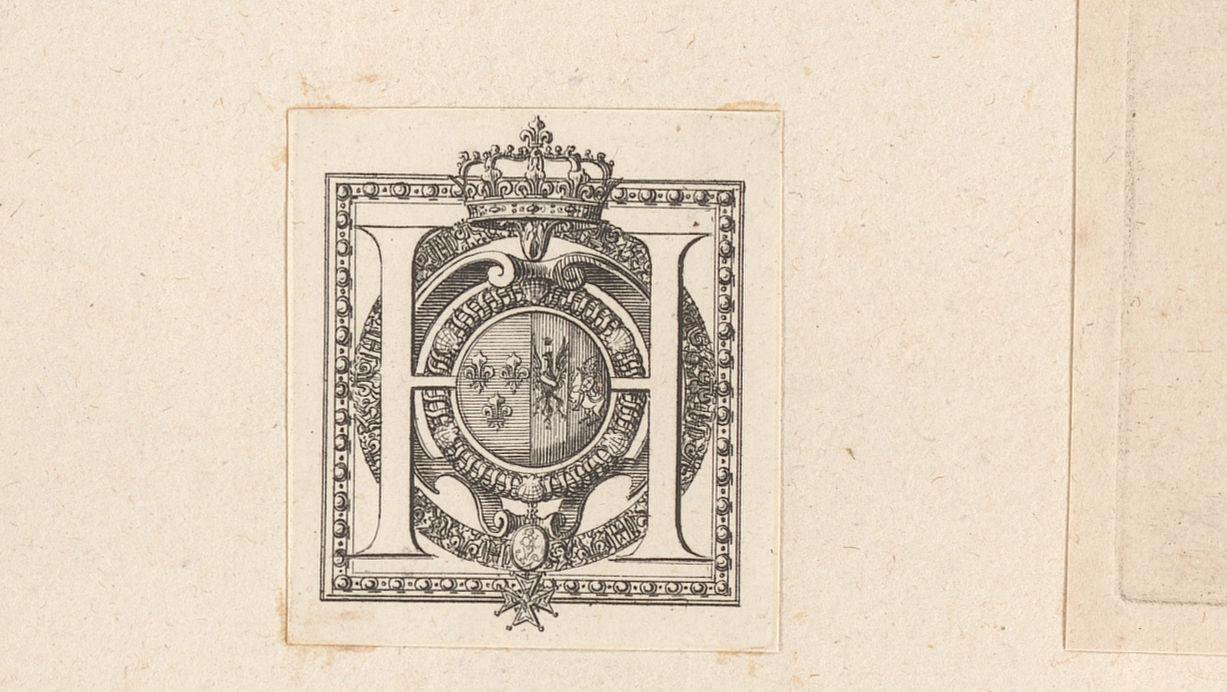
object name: album leaf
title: Initiaal 'H' met het wapen van Hendrik III en twee onderscheidingen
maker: sébastien leclerc (i)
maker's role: print maker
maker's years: 1637-1714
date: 1703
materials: paper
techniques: etching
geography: paris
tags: initial, knighthood order of the holy spirit - insignia of a knighthood order, e.g.: badge, chain (with name of order), insignia and symbols of sovereignty (crown, diadem, sceptre, orb, seal, standard, cloak, pectoral)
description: Initiaal gebruikt voor: Les Statuts de l'ordre du Saint-Esprit. Parijs: Imprimerie Royale, 1703.